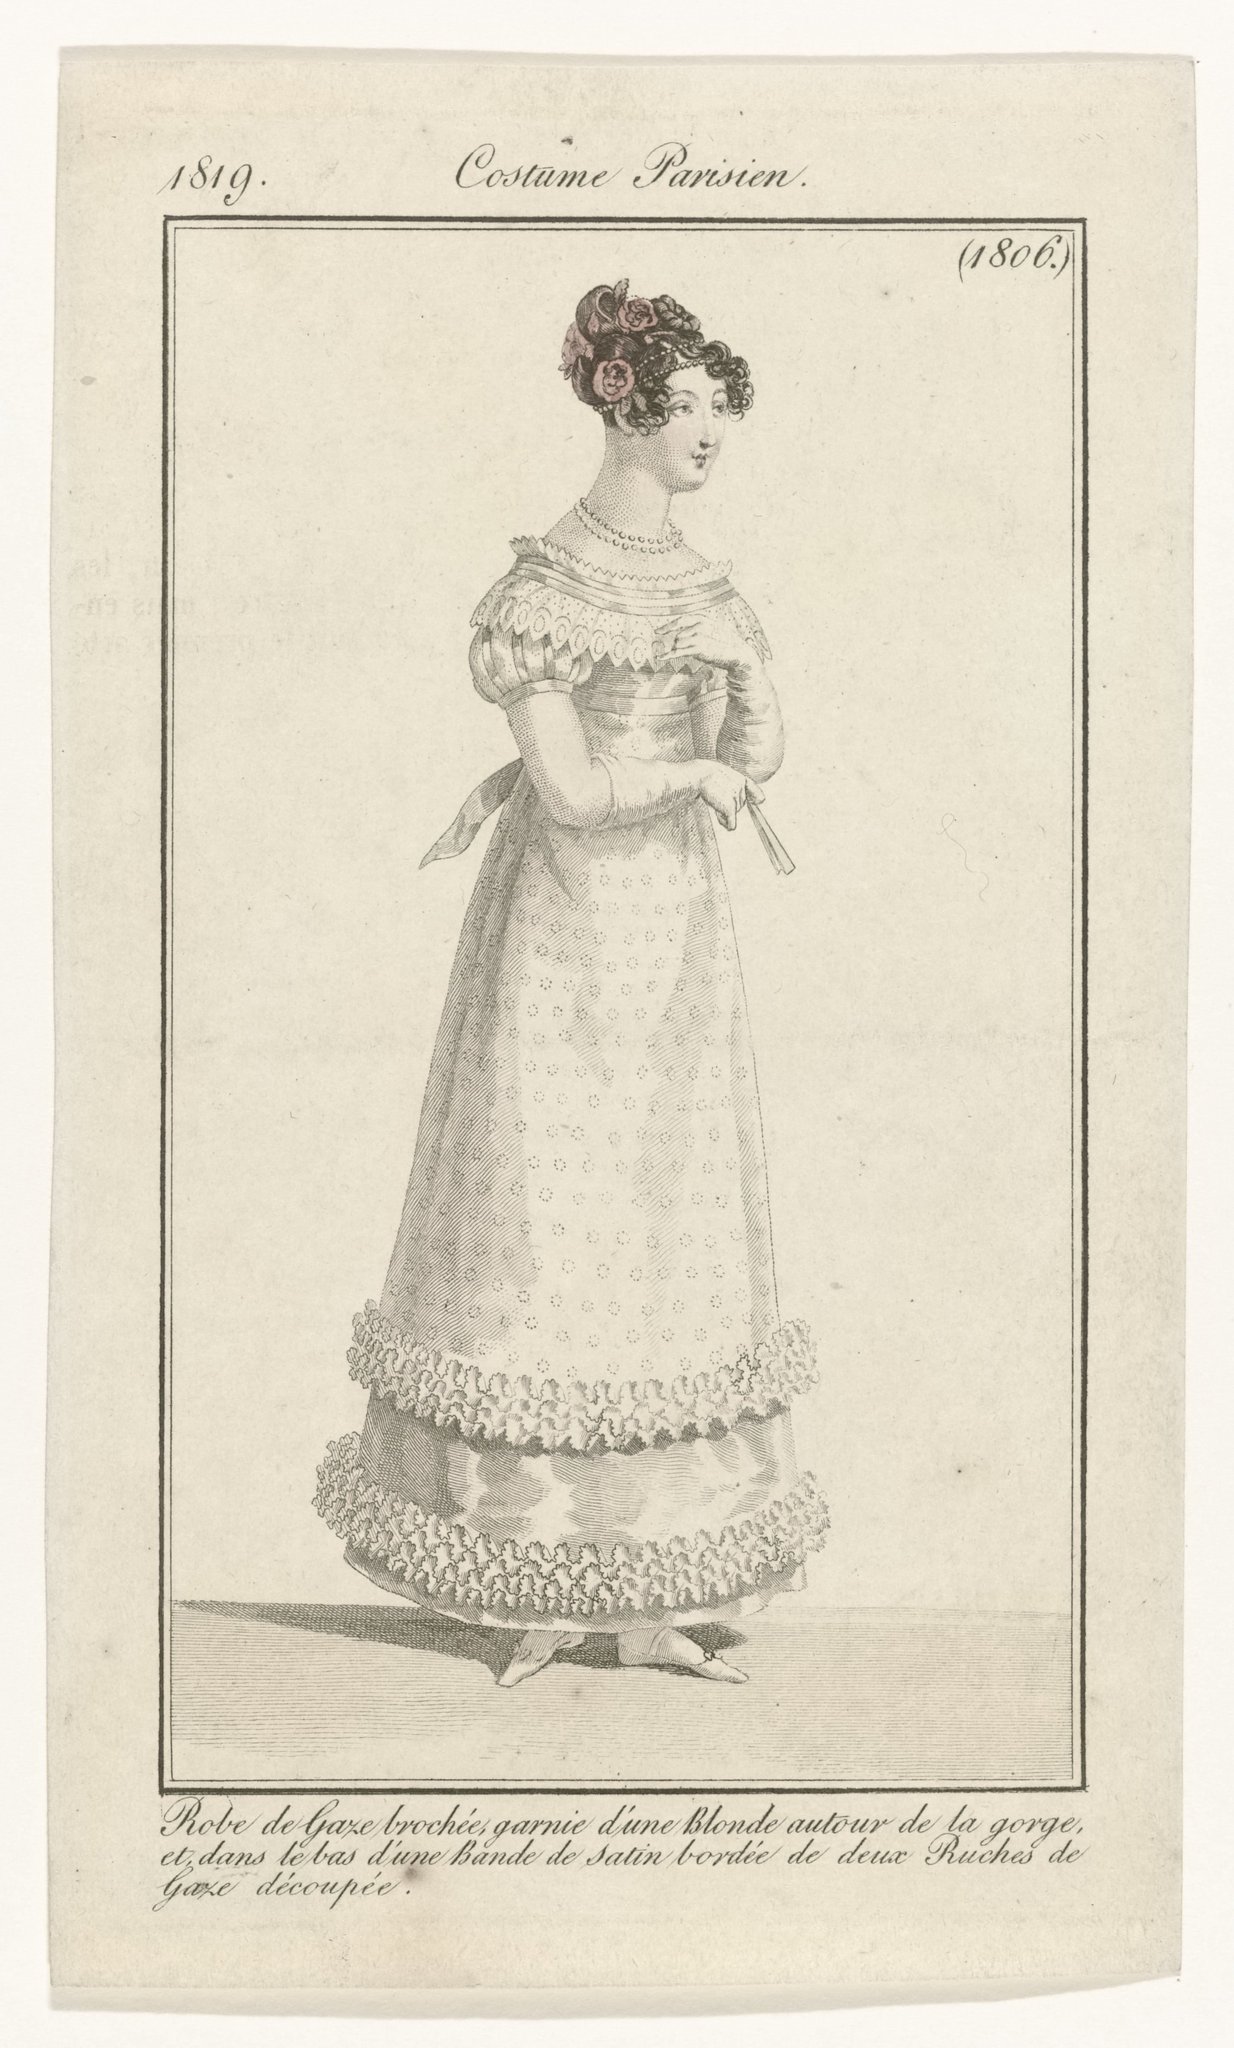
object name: fashion print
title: Journal des Dames et des Modes, Costume Parisien, 5 avril 1819, (1806): Robe de Gaze broché (...)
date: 1819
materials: paper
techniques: engraving, hand coloring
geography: paris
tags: diadem, tiara (+ women's clothes), fashion plates, dress, gown (+ women's clothes), fan (+ women's clothes)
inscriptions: caption: ‘Robe de Gaze brochée, garnie d'une Blonde autour de la gorge, et dans le bas d'une Bande de Satin bordée de deux Ruches de Gaze découpée.’, title: ‘Costume Parisien.’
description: Staande vrouw gekleed in een japon van gebrocheerde tule gegarneerd met een 'Blonde autour de la gorge' en aan de onderkant een band van satijn afgezet met twee ruches van tule. Accessoires: collier, lange handschoenen, waaier, schoenen. De prent maakt deel uit van het modetijdschrift Journal des Dames et des Modes, uitgegeven door Pierre de la Mésangère, Parijs, 1797-1839.